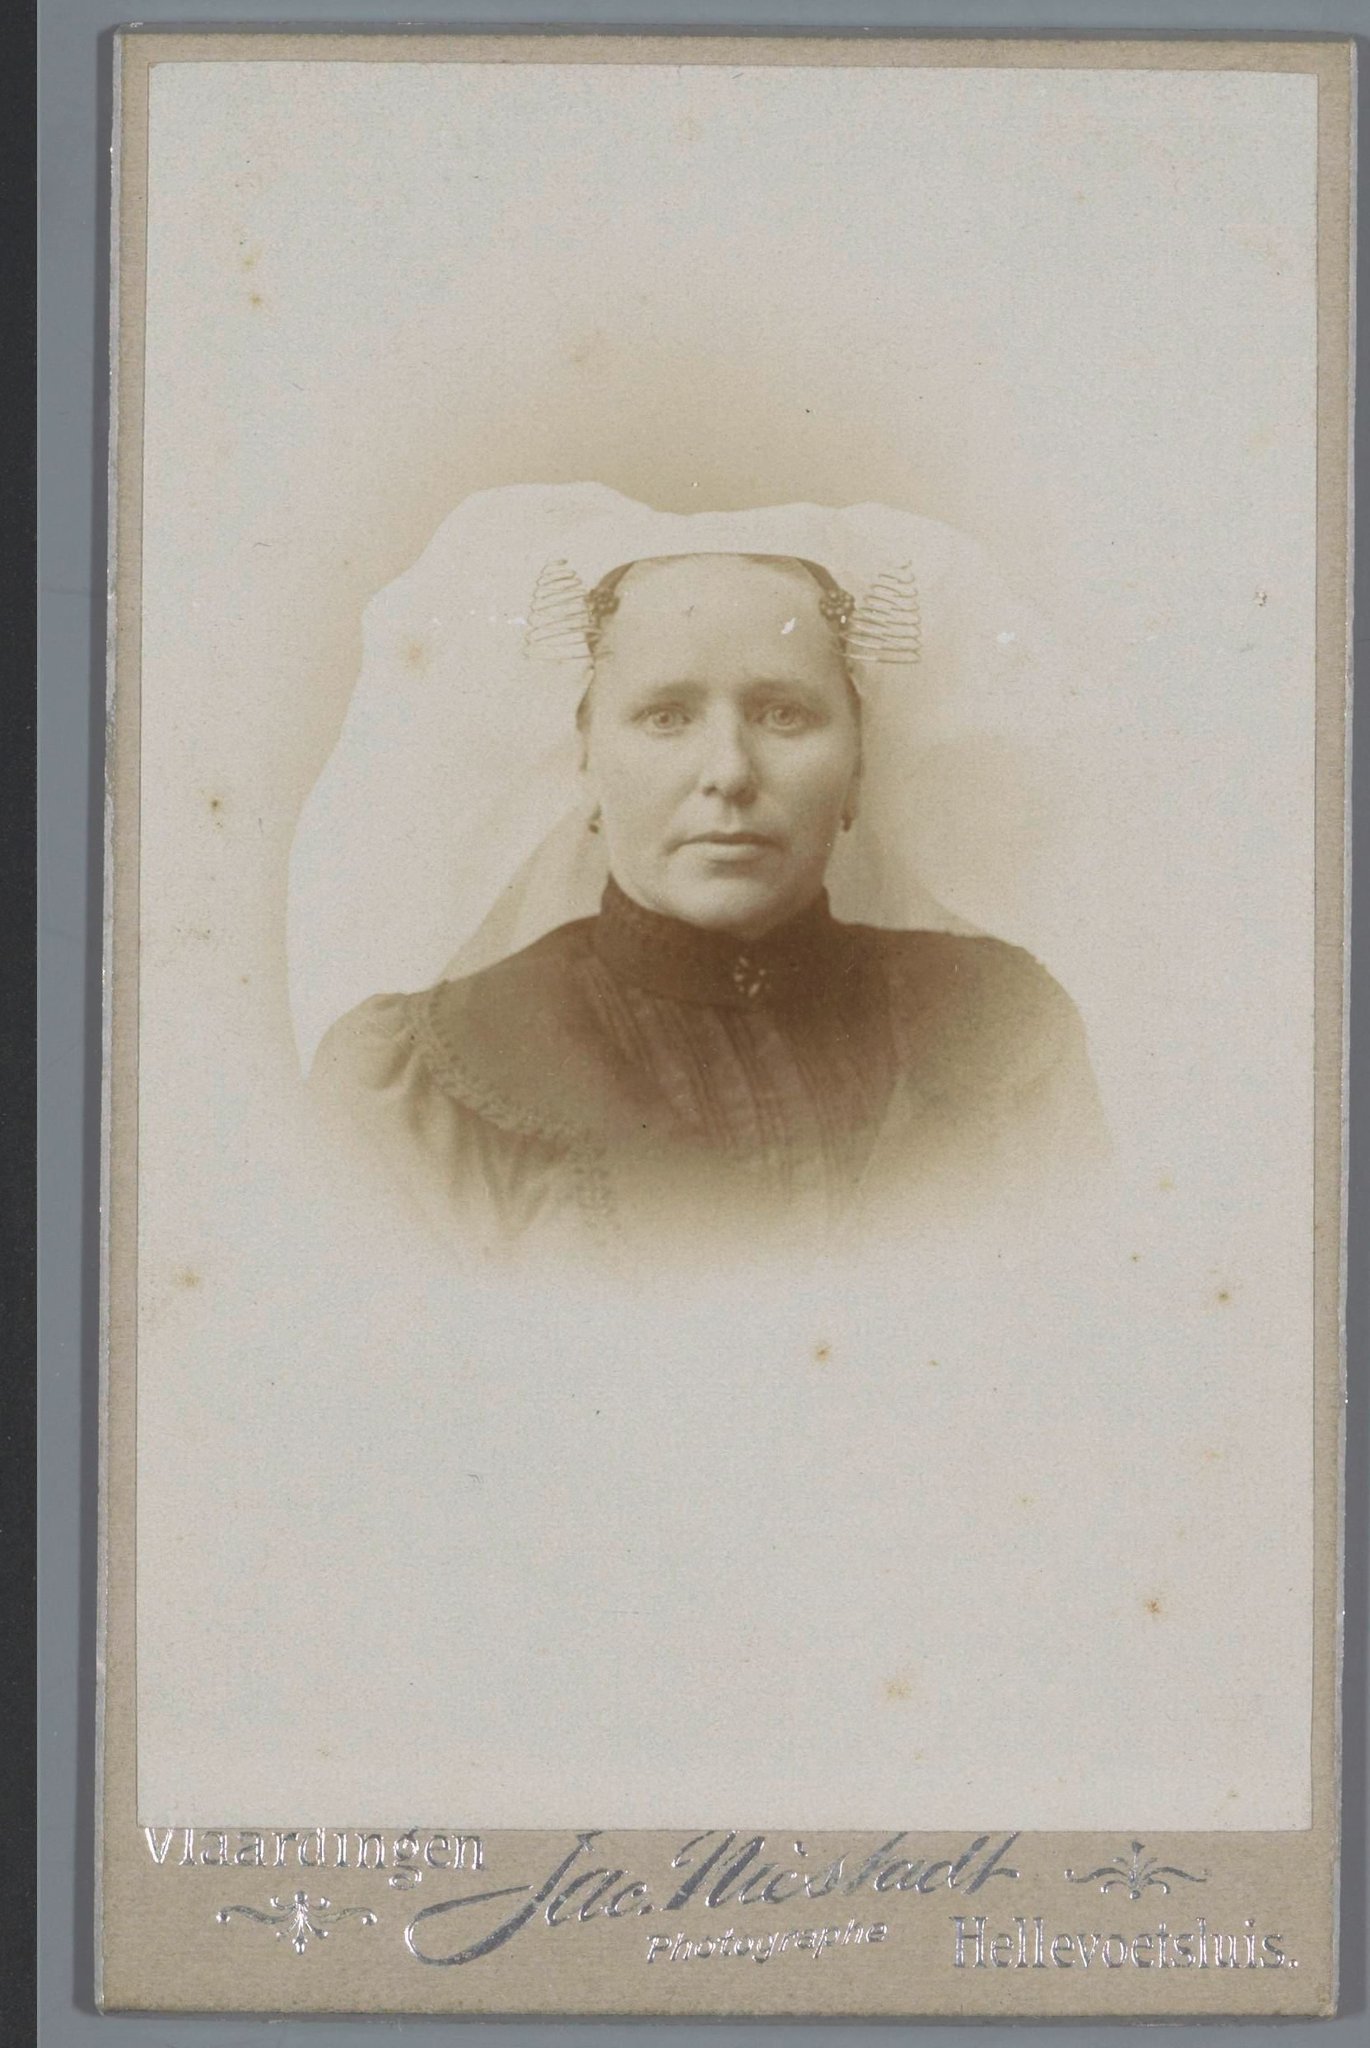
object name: photograph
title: Portret van een onbekende vrouw in Overmaasse klederdracht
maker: jacob niestadt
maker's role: fotograaf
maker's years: 1872-1916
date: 1893-1916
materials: paper, cardboard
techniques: collodion silver print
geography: vlaardingen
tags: adult woman, head-gear: cap, anonymous historical person portrayed, folk costume, regional costume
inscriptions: inscription: ‘Vlaardingen/ Jac. Niestadt/ Photographe/ Hellevoetsluis’